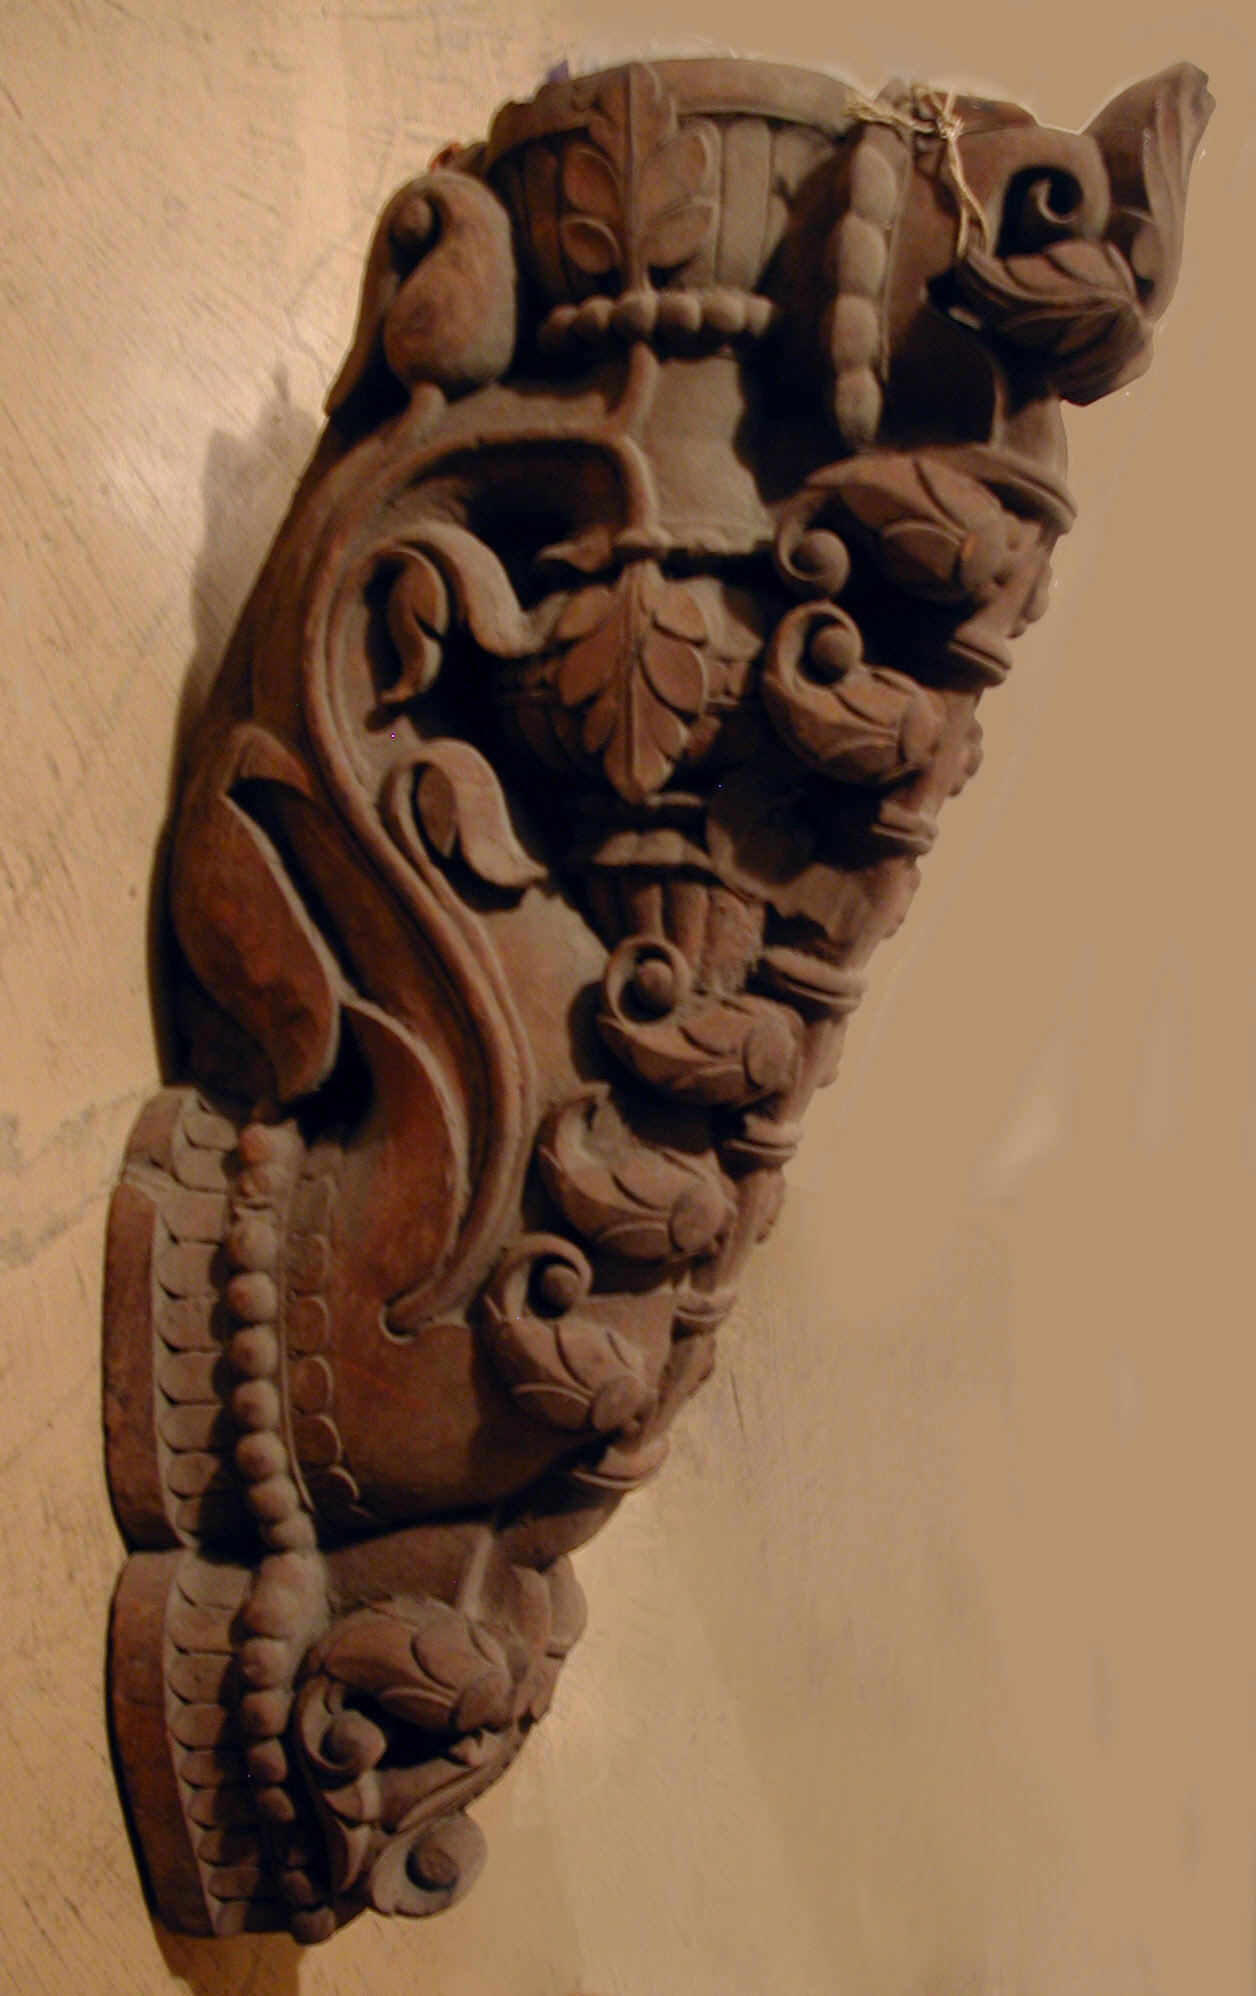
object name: bracket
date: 1601-1700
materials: wood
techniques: carving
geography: india